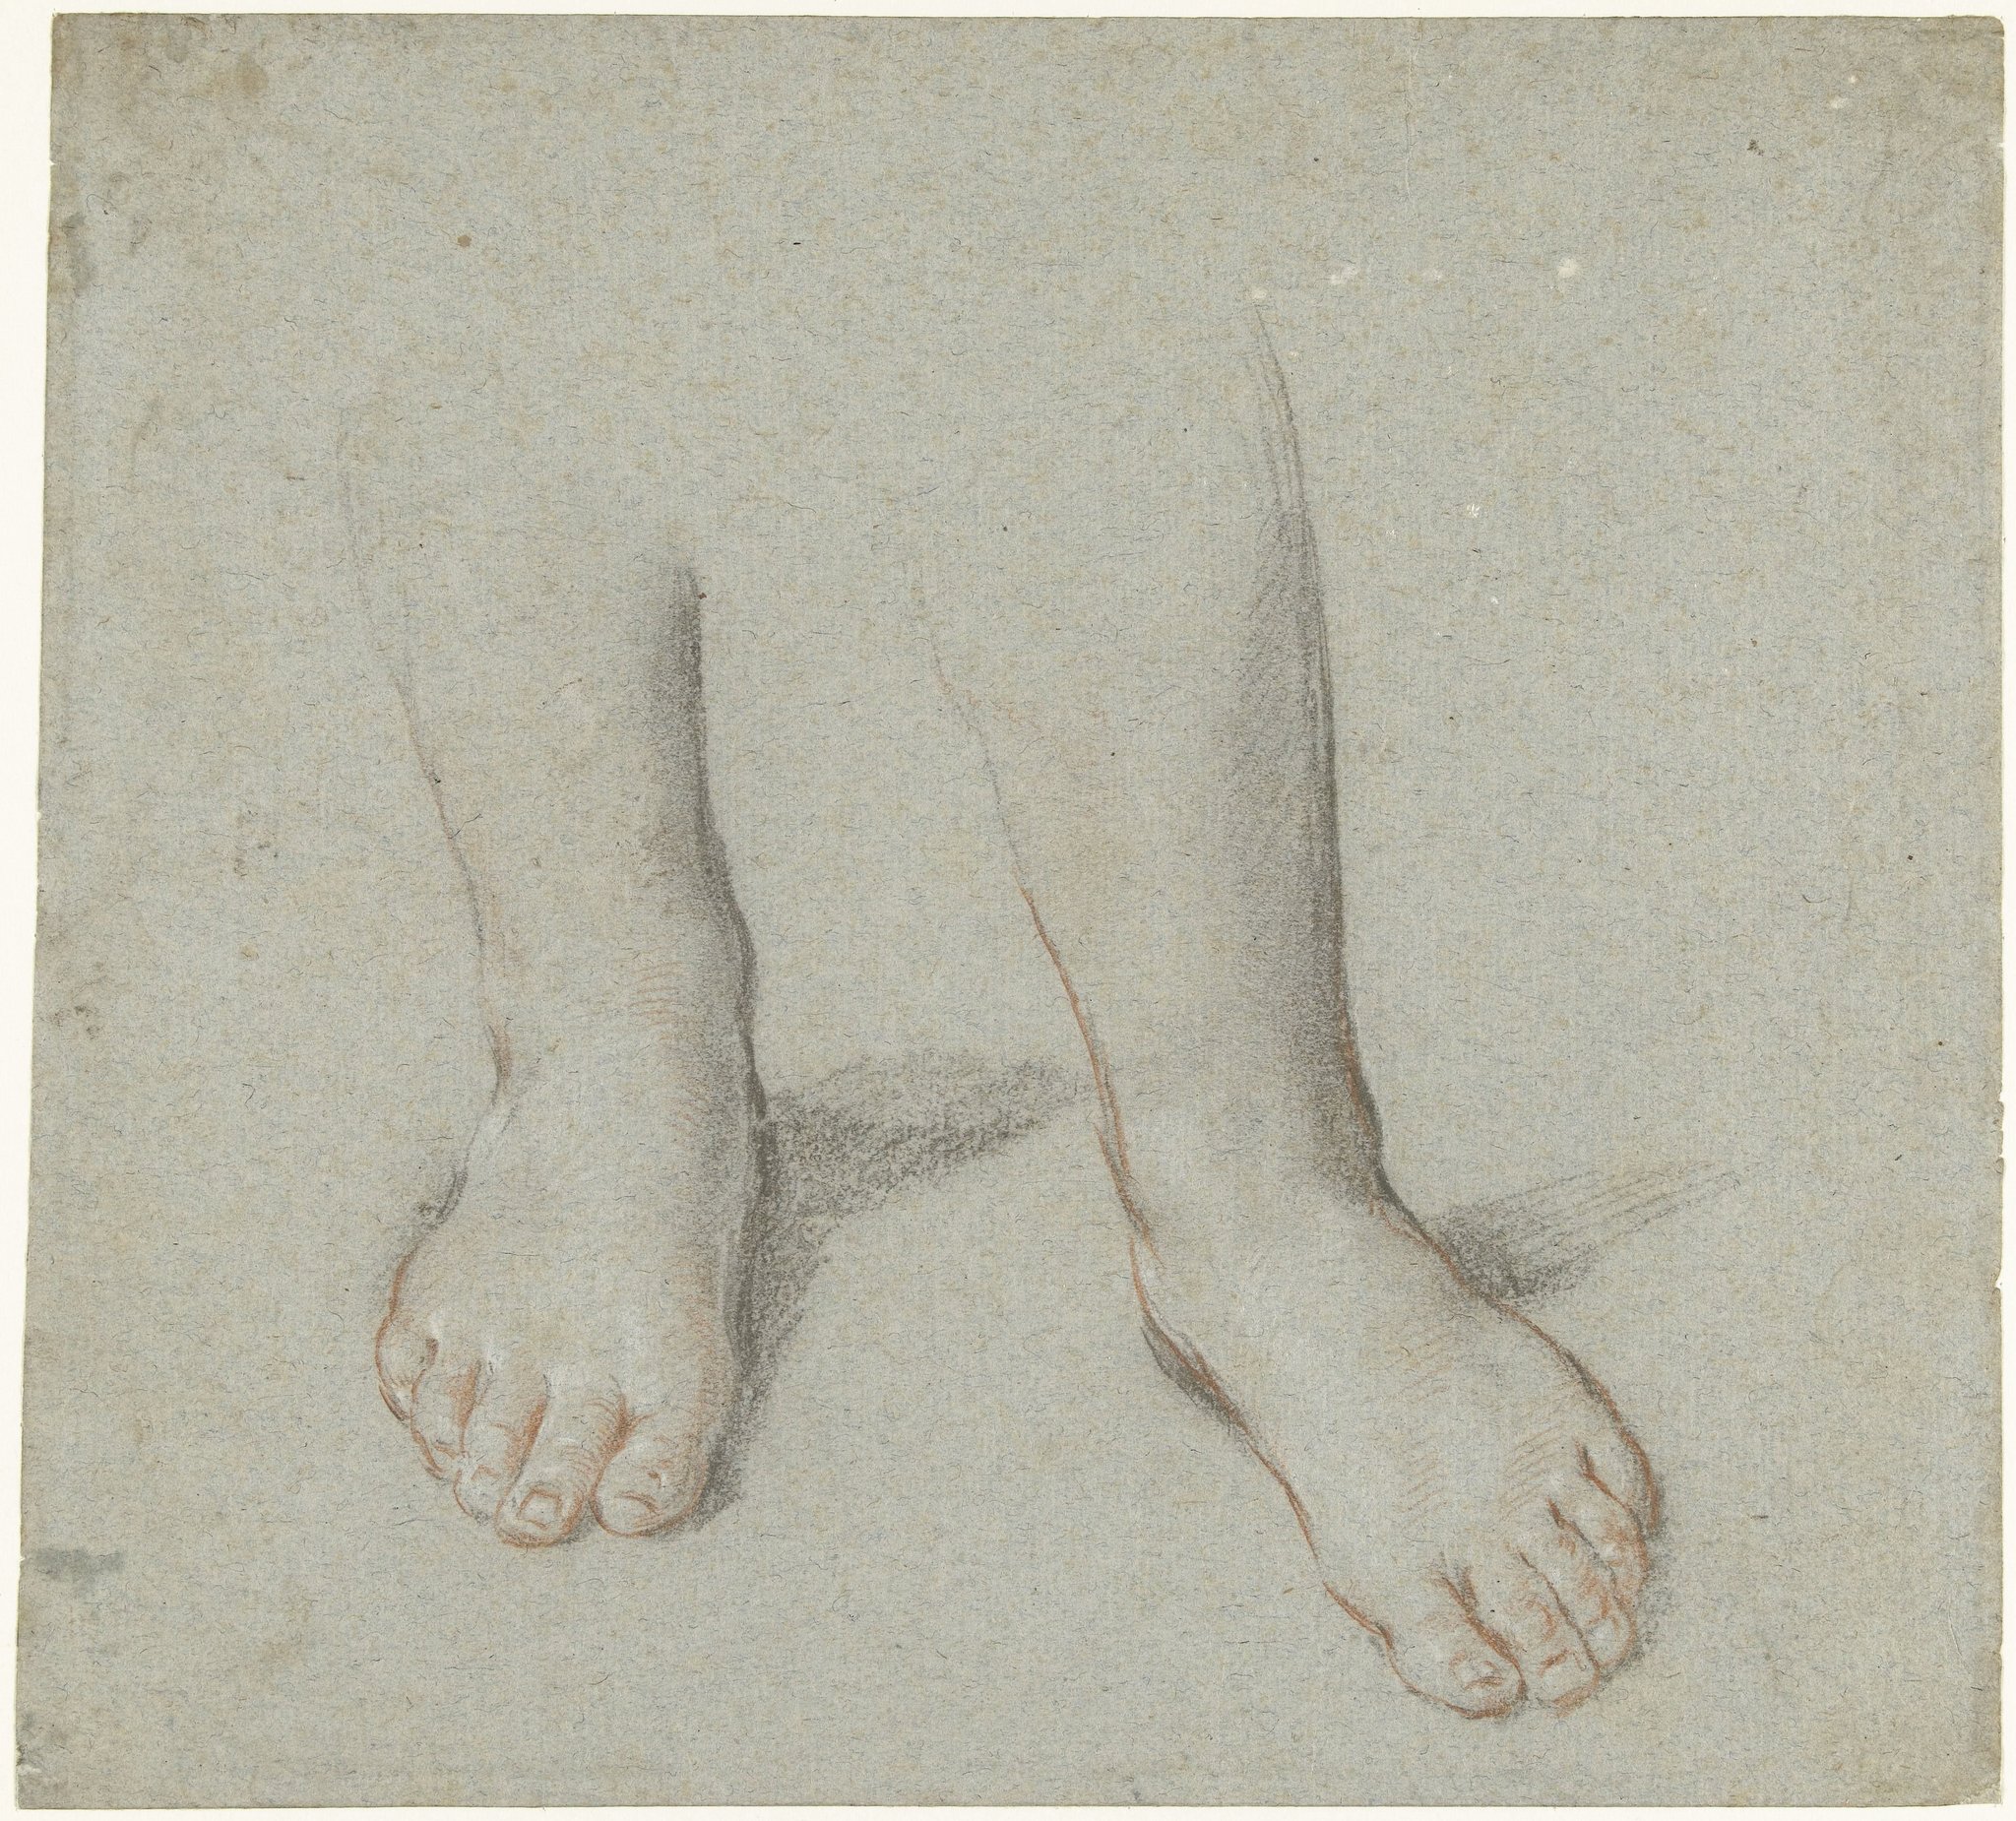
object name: drawing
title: Twee vrouwenvoeten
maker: guido reni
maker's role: draughtsman, painter, print maker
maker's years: 1575-1642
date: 1585-1642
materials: chalk, paper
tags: foot